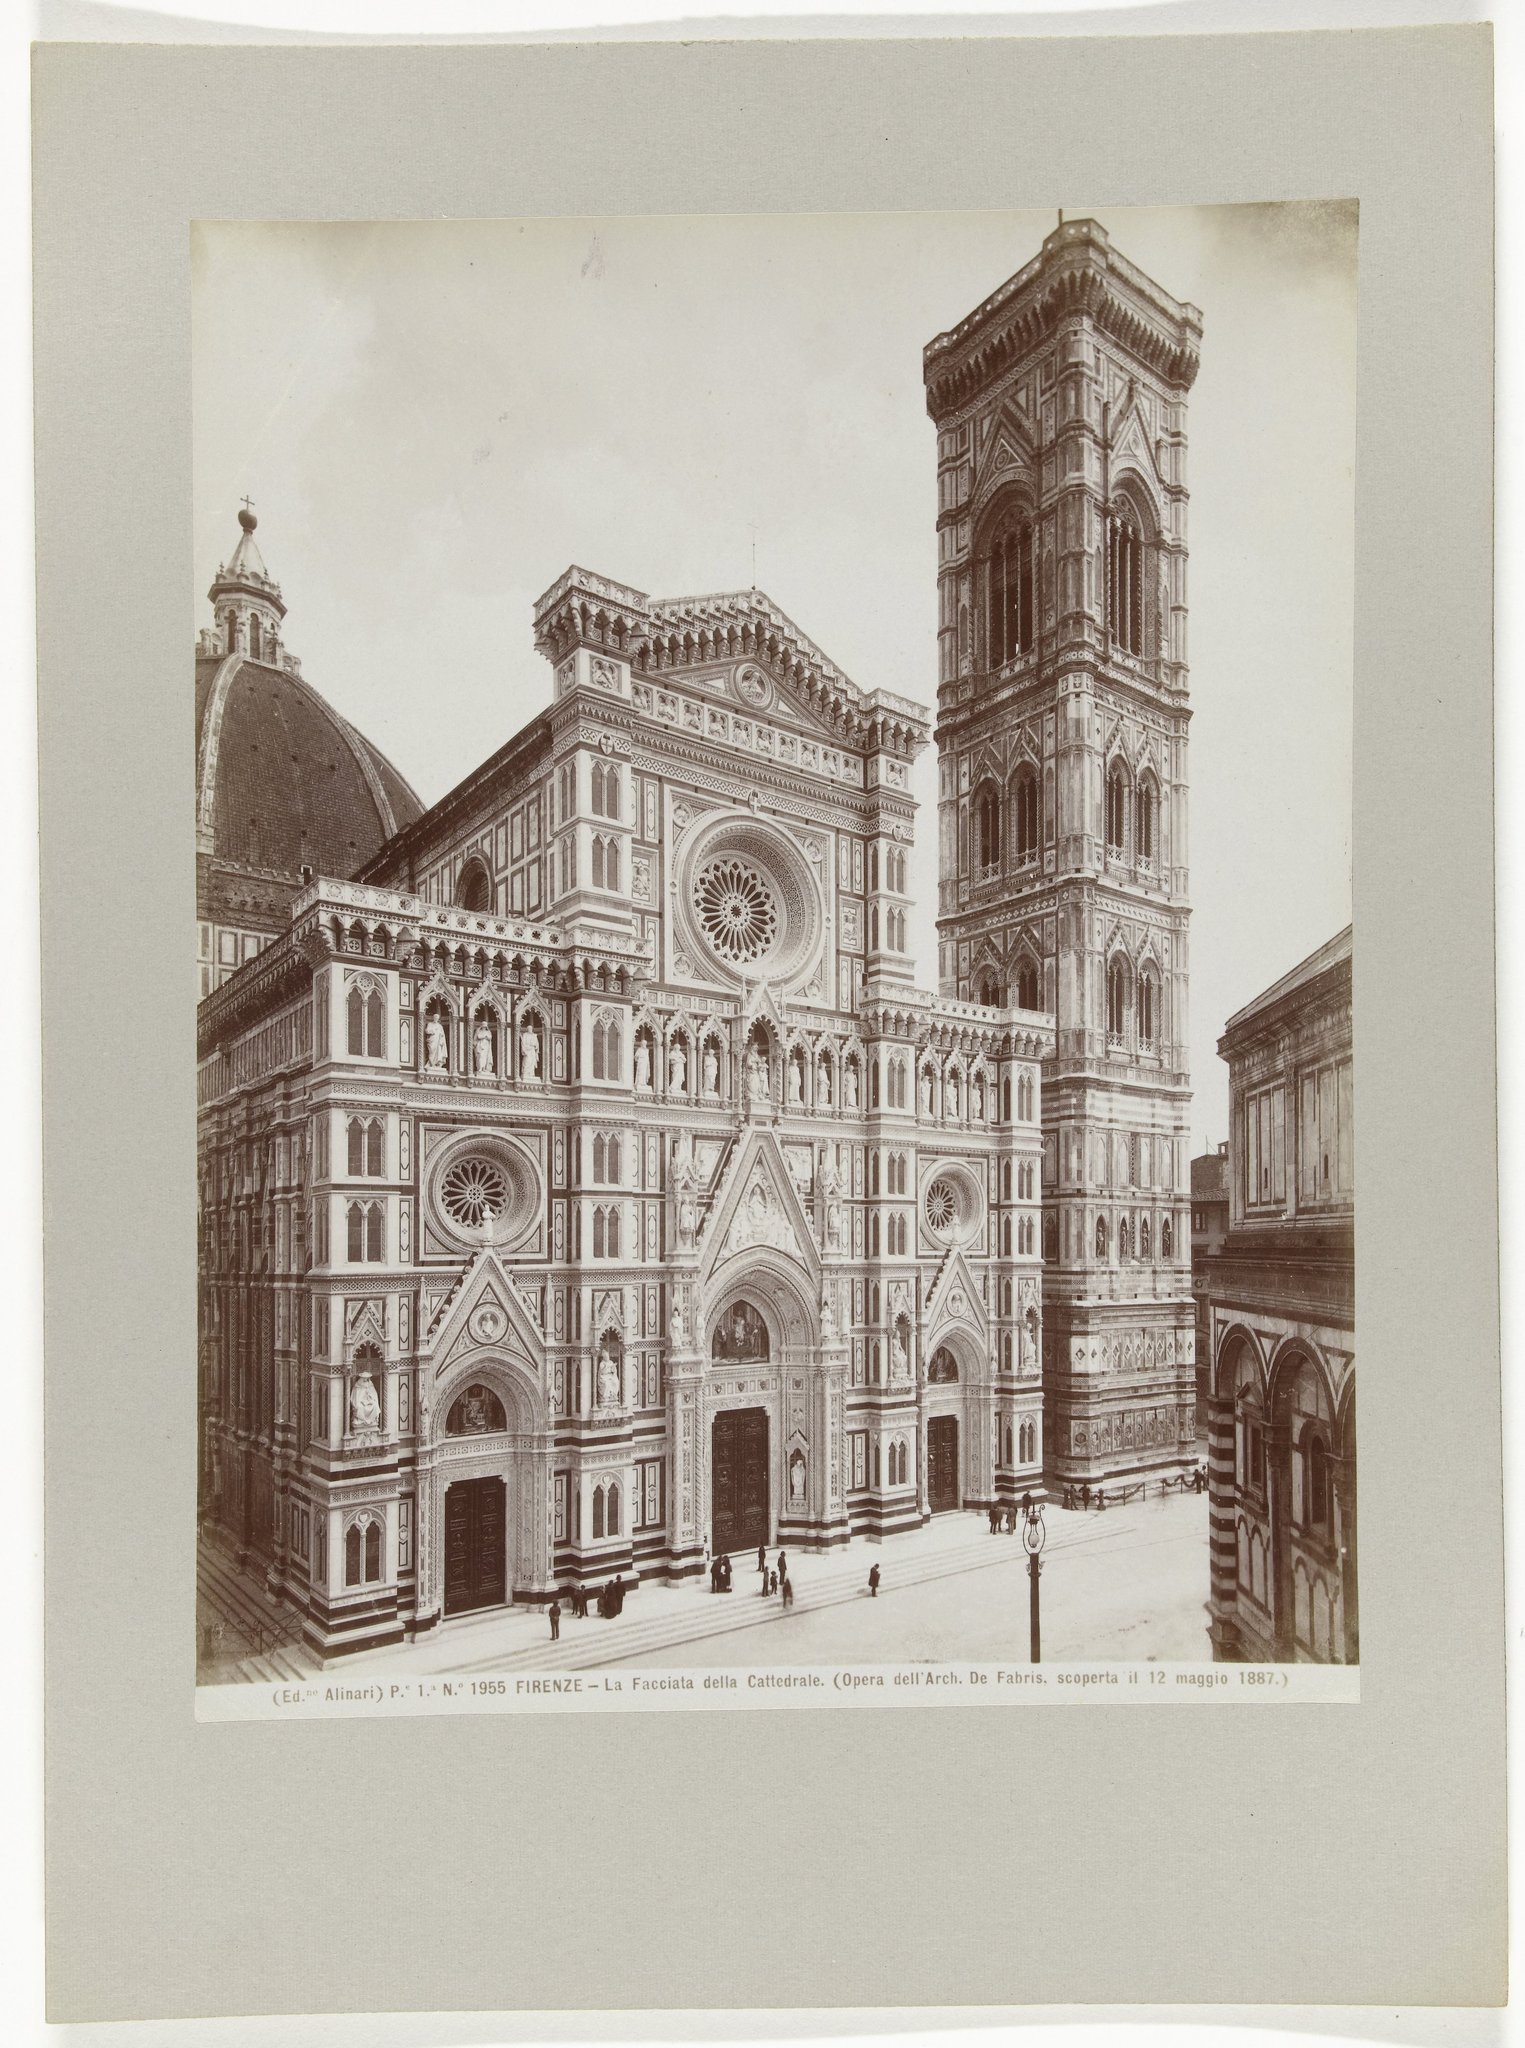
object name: photograph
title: P.e 1.a N.o 1955 FIRENZE - La Facciata della Cattedrale. (Opera dell'Arch. De Fabris, scoperta il 12 maggio 1887.)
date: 1887-1895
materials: cardboard, paper, photographic support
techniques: albumen print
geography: florence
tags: church (exterior), tower (of house or building)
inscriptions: number: ‘76.’